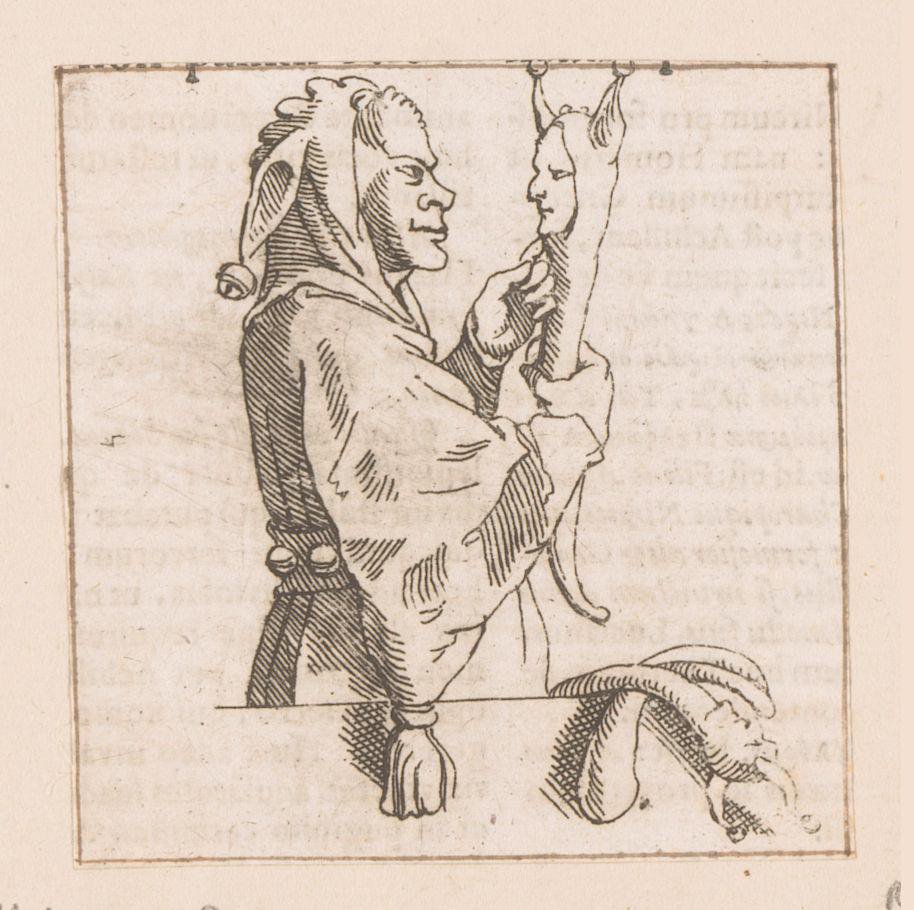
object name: print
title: Nar met een zotskolf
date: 1516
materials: paper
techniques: etching, letterpress printing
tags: rotterdam, desiderius erasmus, court jester, court fool, bauble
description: Prent afkomstig uit: Erasmus, Desiderius. Morias enkomion (...). Bazel: Johann Rudolf Genath, 1676. De prenten hierin zijn naar tekeningen die Hans en Ambrosius Holbein maakten voor de theoloog Oswald Myconius in diens uitgave van de Moriae encomium (Lof der Zotheid) van 1516.